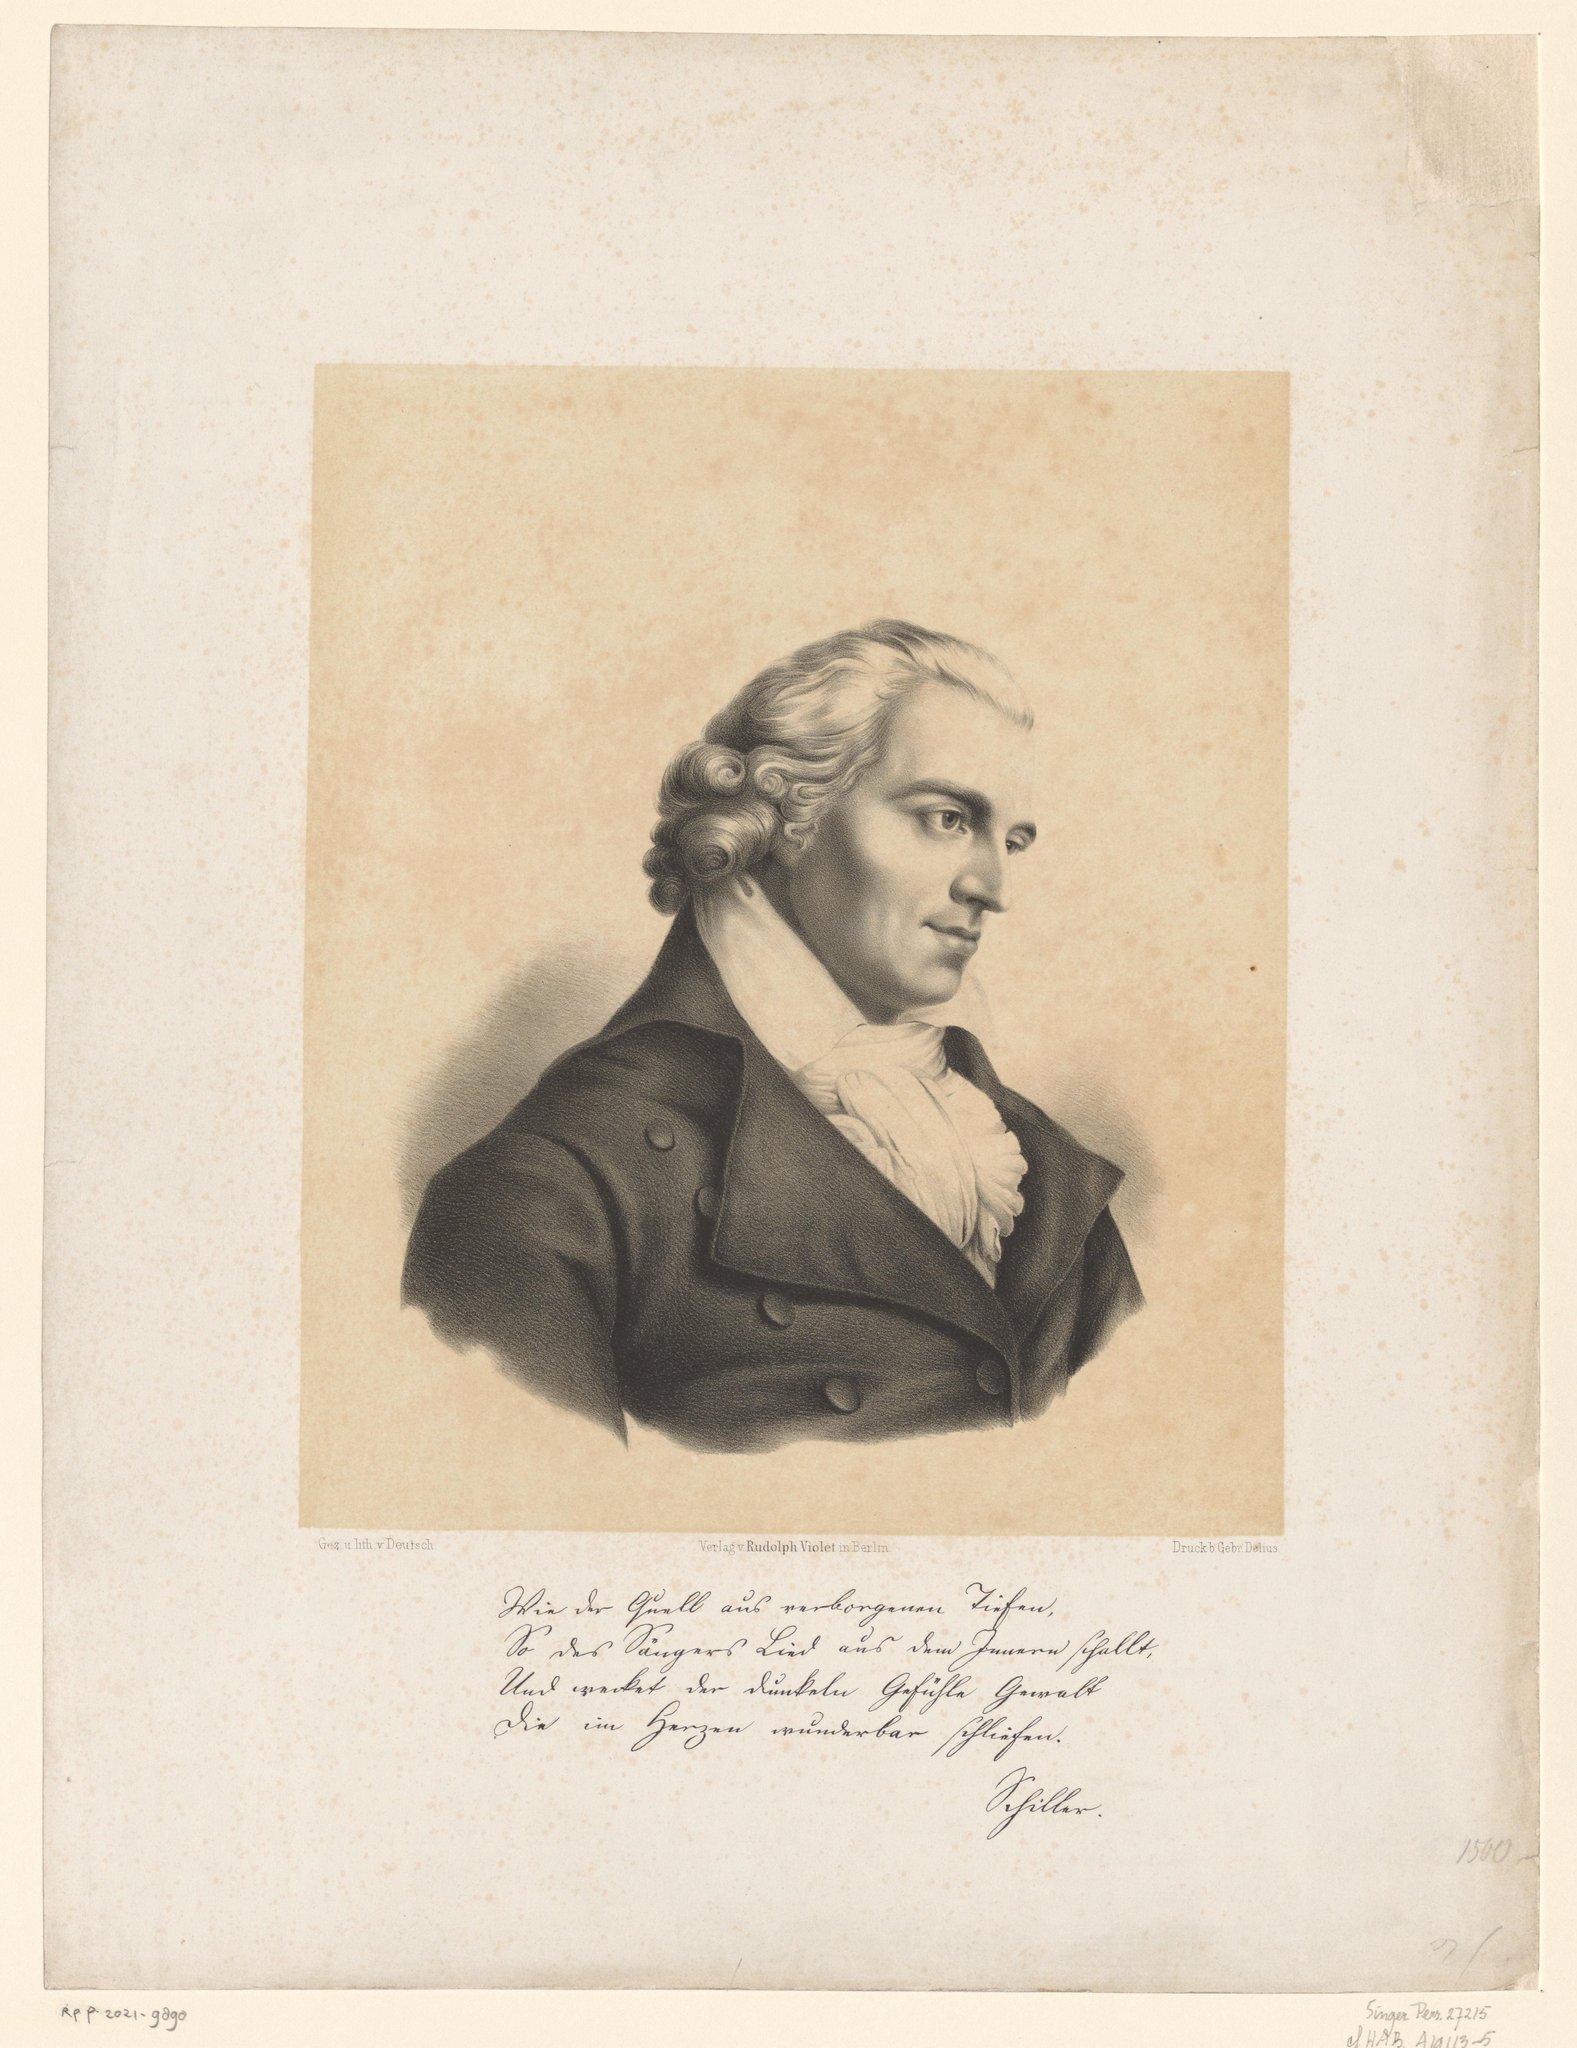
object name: print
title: Portret van Friedrich von Schiller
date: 1840-1850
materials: paper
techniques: tone lithography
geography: berlin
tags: friedrich von schiller, adult man, historical persons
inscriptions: collector's mark: Lugt 2228